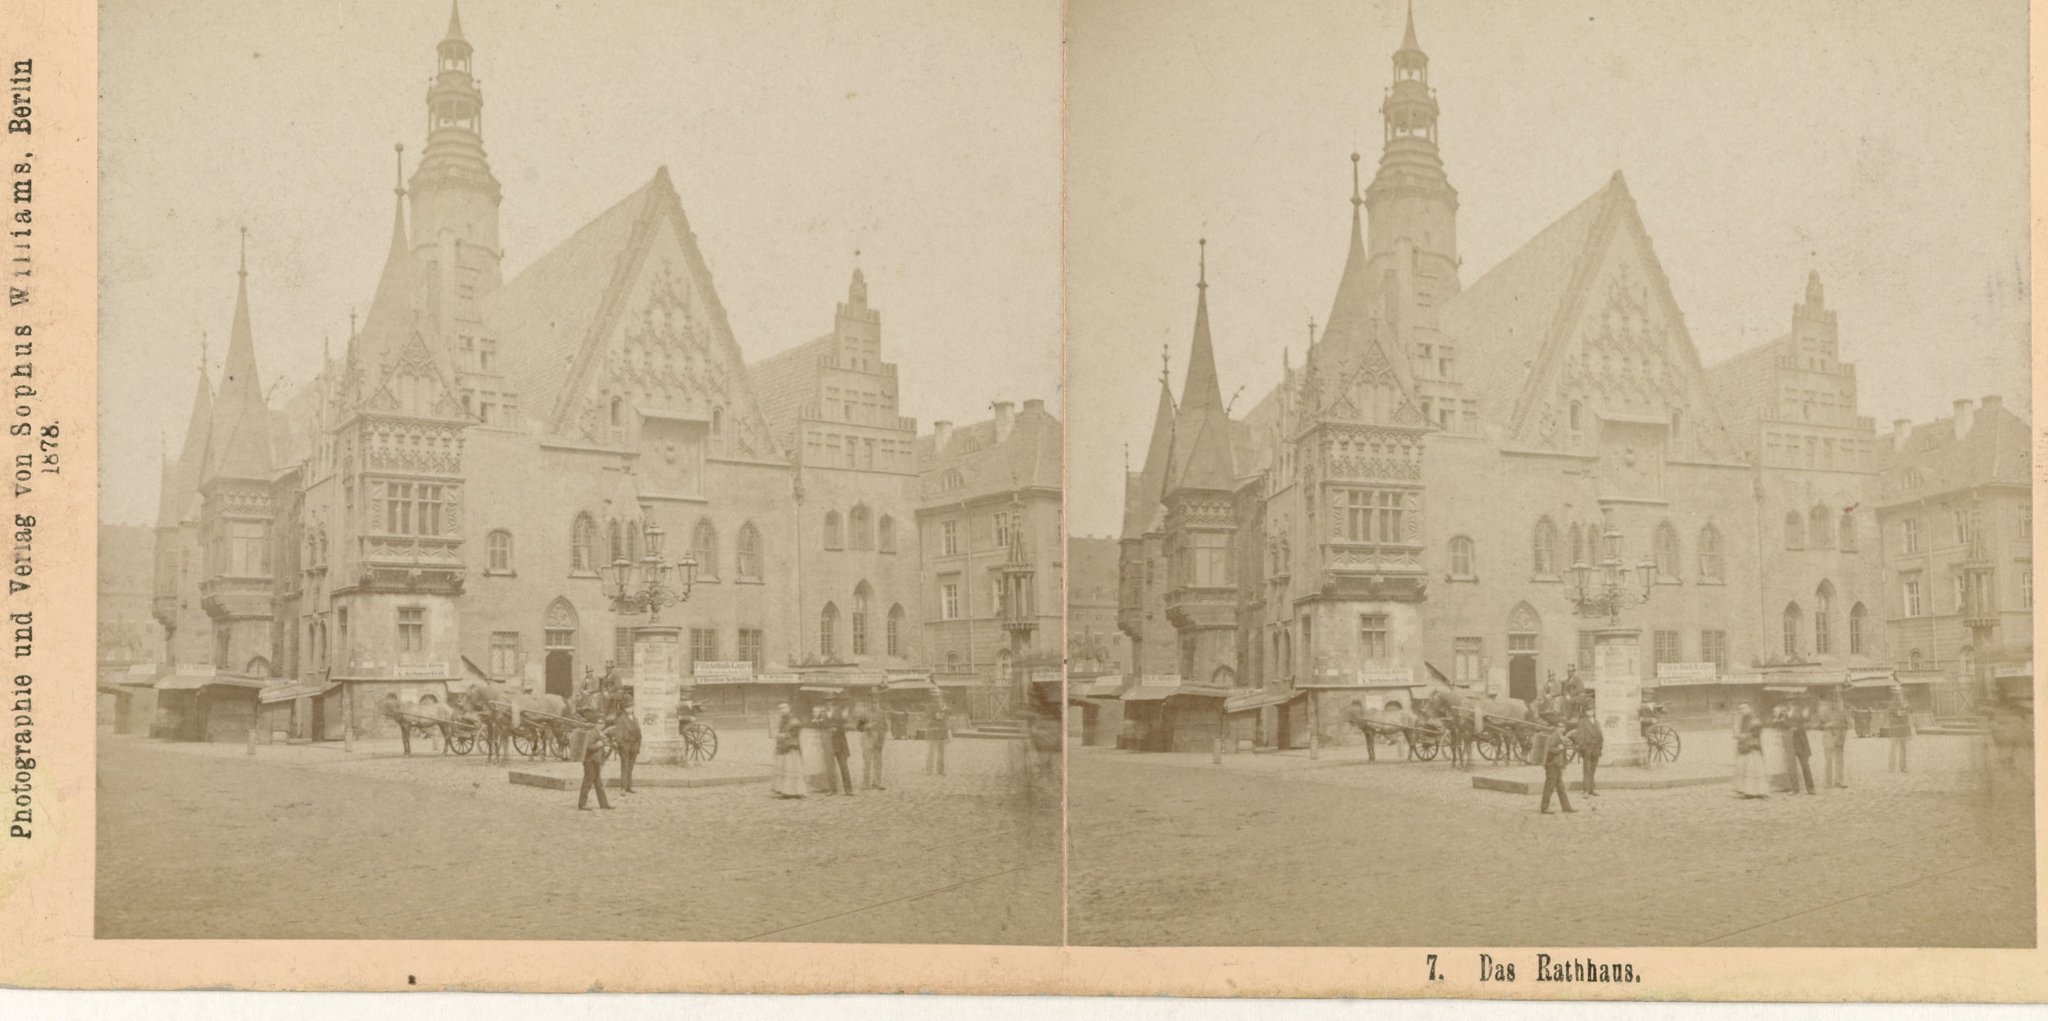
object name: stereograph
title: Stadhuis van Wroclaw, Polen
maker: sophus williams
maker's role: publisher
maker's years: 1835-1900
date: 1878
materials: cardboard, paper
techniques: albumen print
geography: wroclaw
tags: square, place, circus, etc., townhall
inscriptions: number: ‘7.’